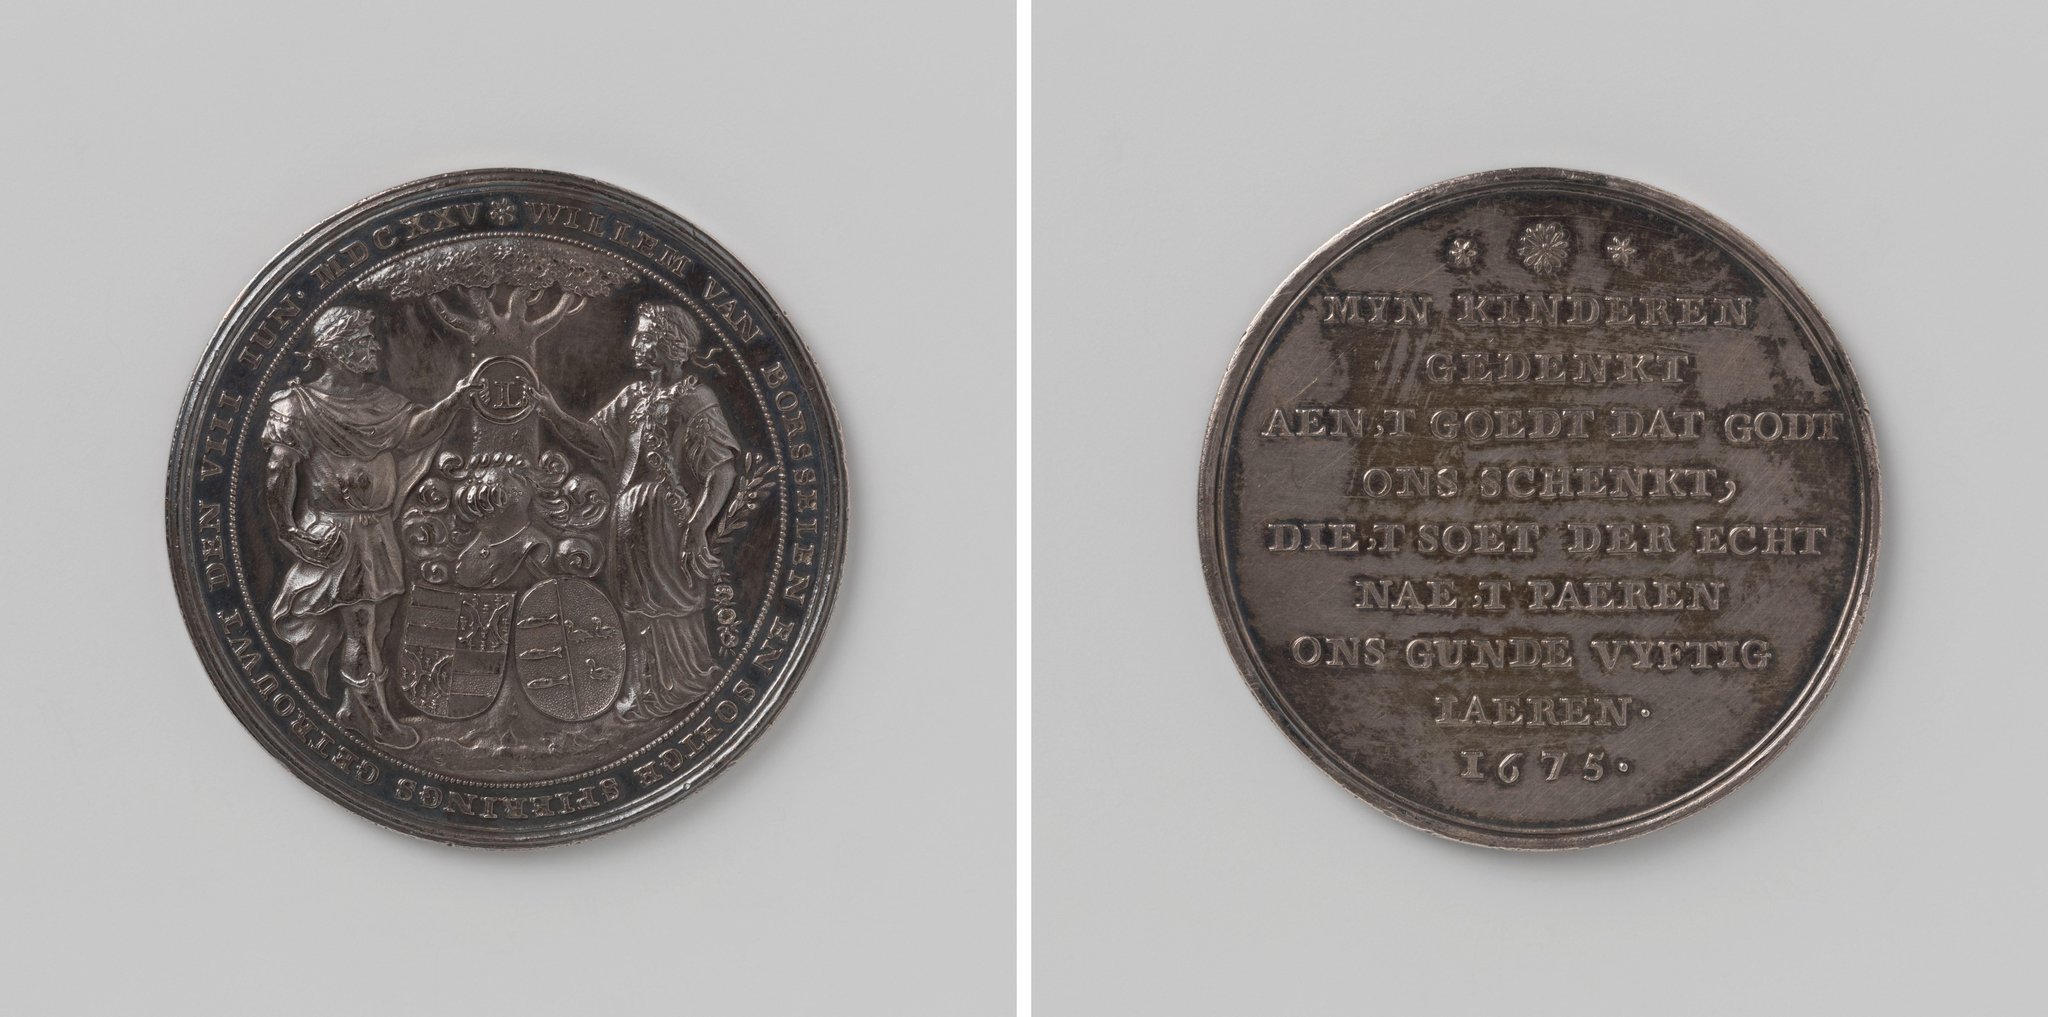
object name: huwelijksjubileumpenning 50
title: Penning ter gelegenheid van het vijftigjarige huwelijk van Willem van Borsselen en Soetge Spierings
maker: Anonymous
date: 1675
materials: silver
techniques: striking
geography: netherlands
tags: armorial bearing, heraldry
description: Penning van zilver, ter gelegenheid van het vijffigjarige huwelijk van Willem van Borsselen en Soetge Spiegins. Voorzijde: man en vrouw die samen ring vasthouden met daarin de letter L, staande voor boom, tussen hen in twee met helm bekroonde wapenschilden binnen omschrift: WILLEM VAN BORSSELEN EN SOETGE SPIERINGS GETROUWT DEN VLII JUN. MDCXXV. Op de keerzijde de tekst: MYN INDEREN GEDENKT AEN 'T GOEDT DAT GODT ONS SCHENKT, DIE 'T SOET DER ECHT NAE 'T PAEREN ONS GUNDE VYFTIG JAEREN 1675